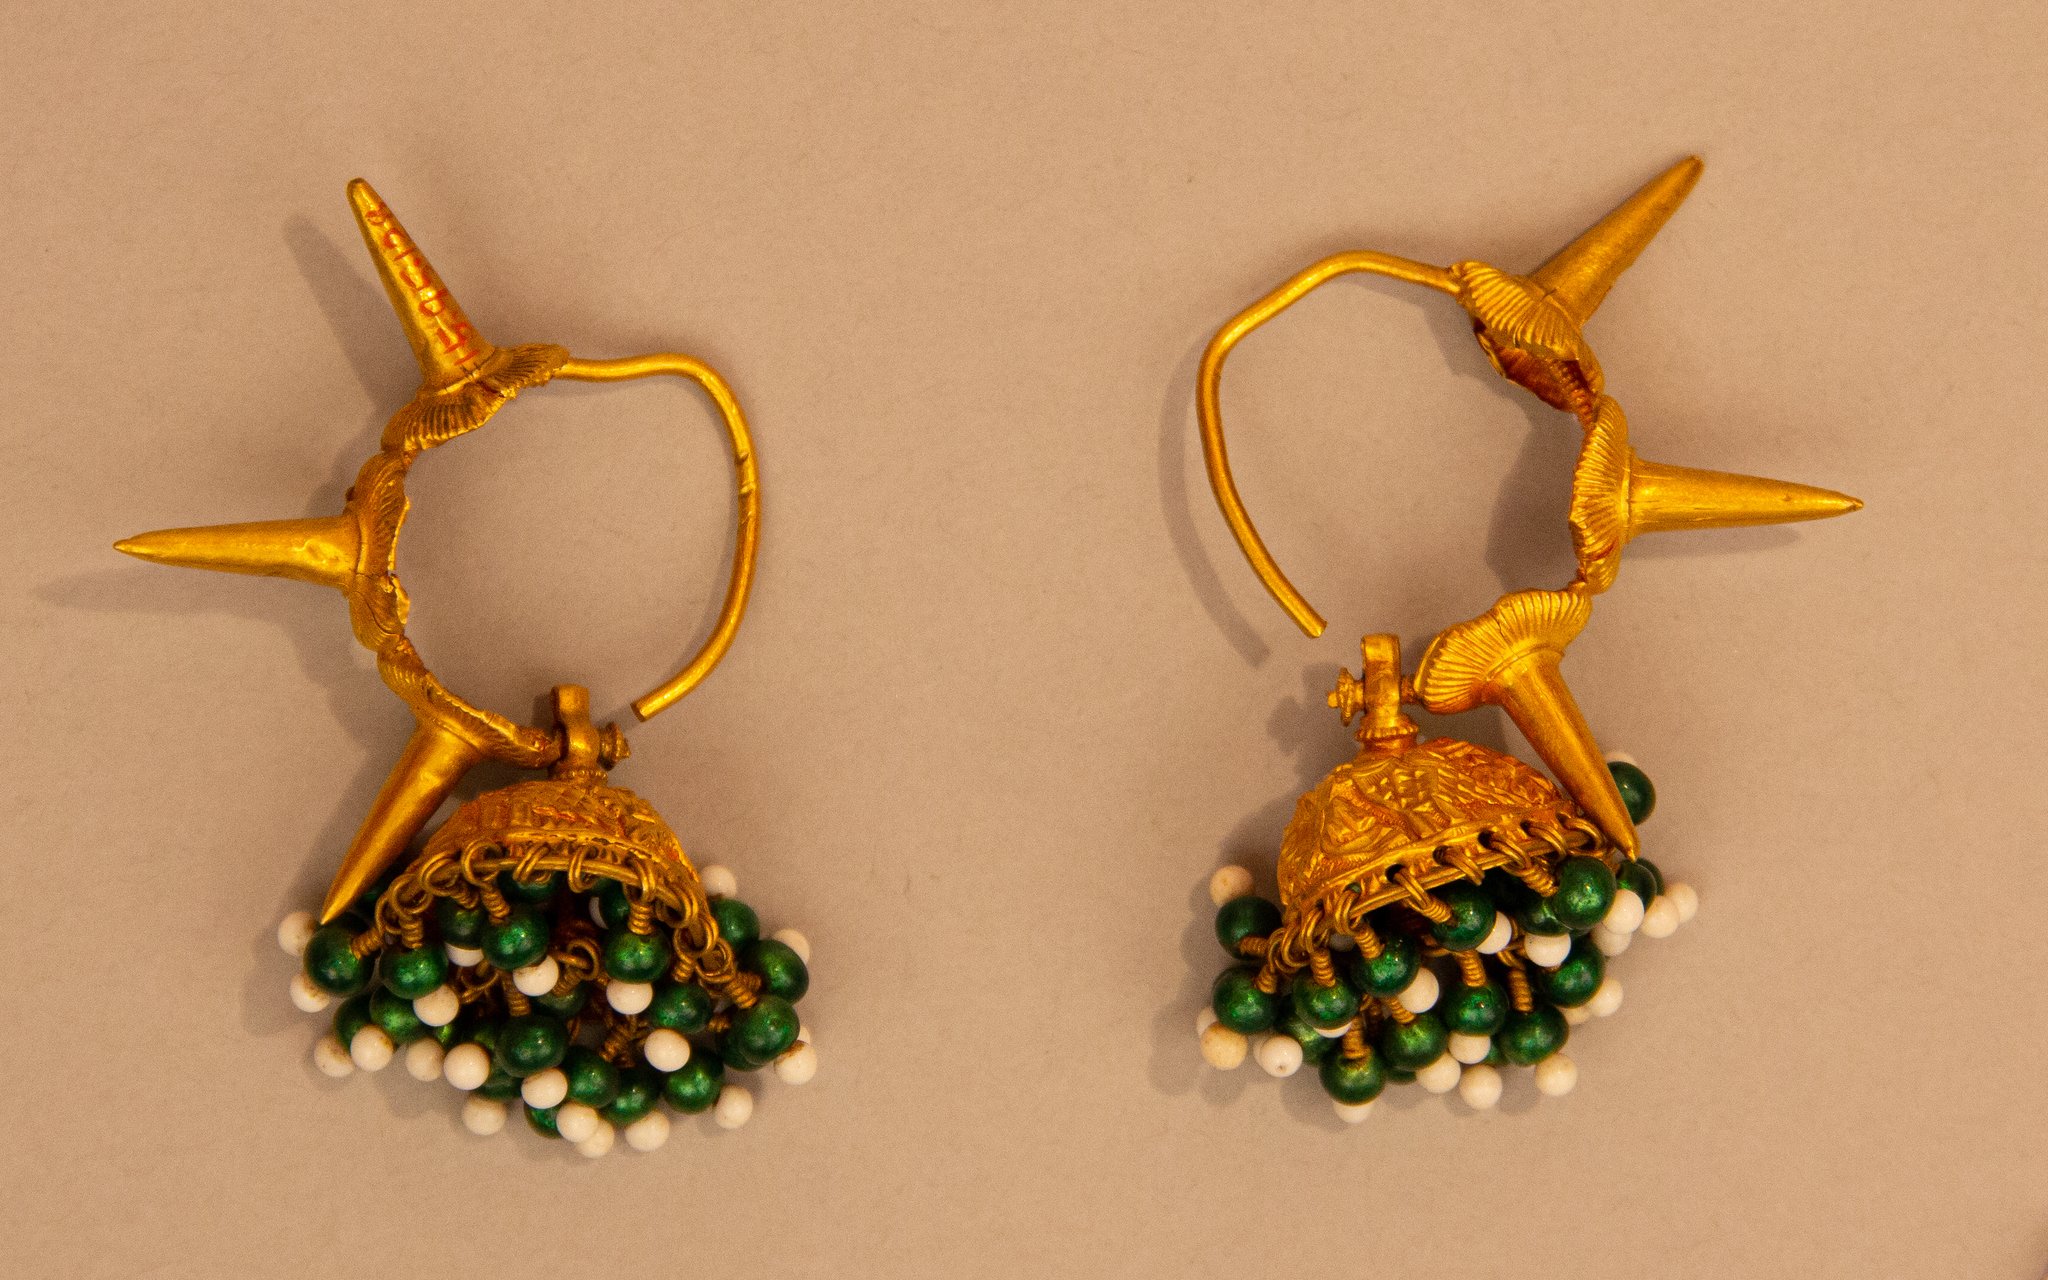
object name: earring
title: Earrings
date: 1701-1900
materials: gold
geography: india